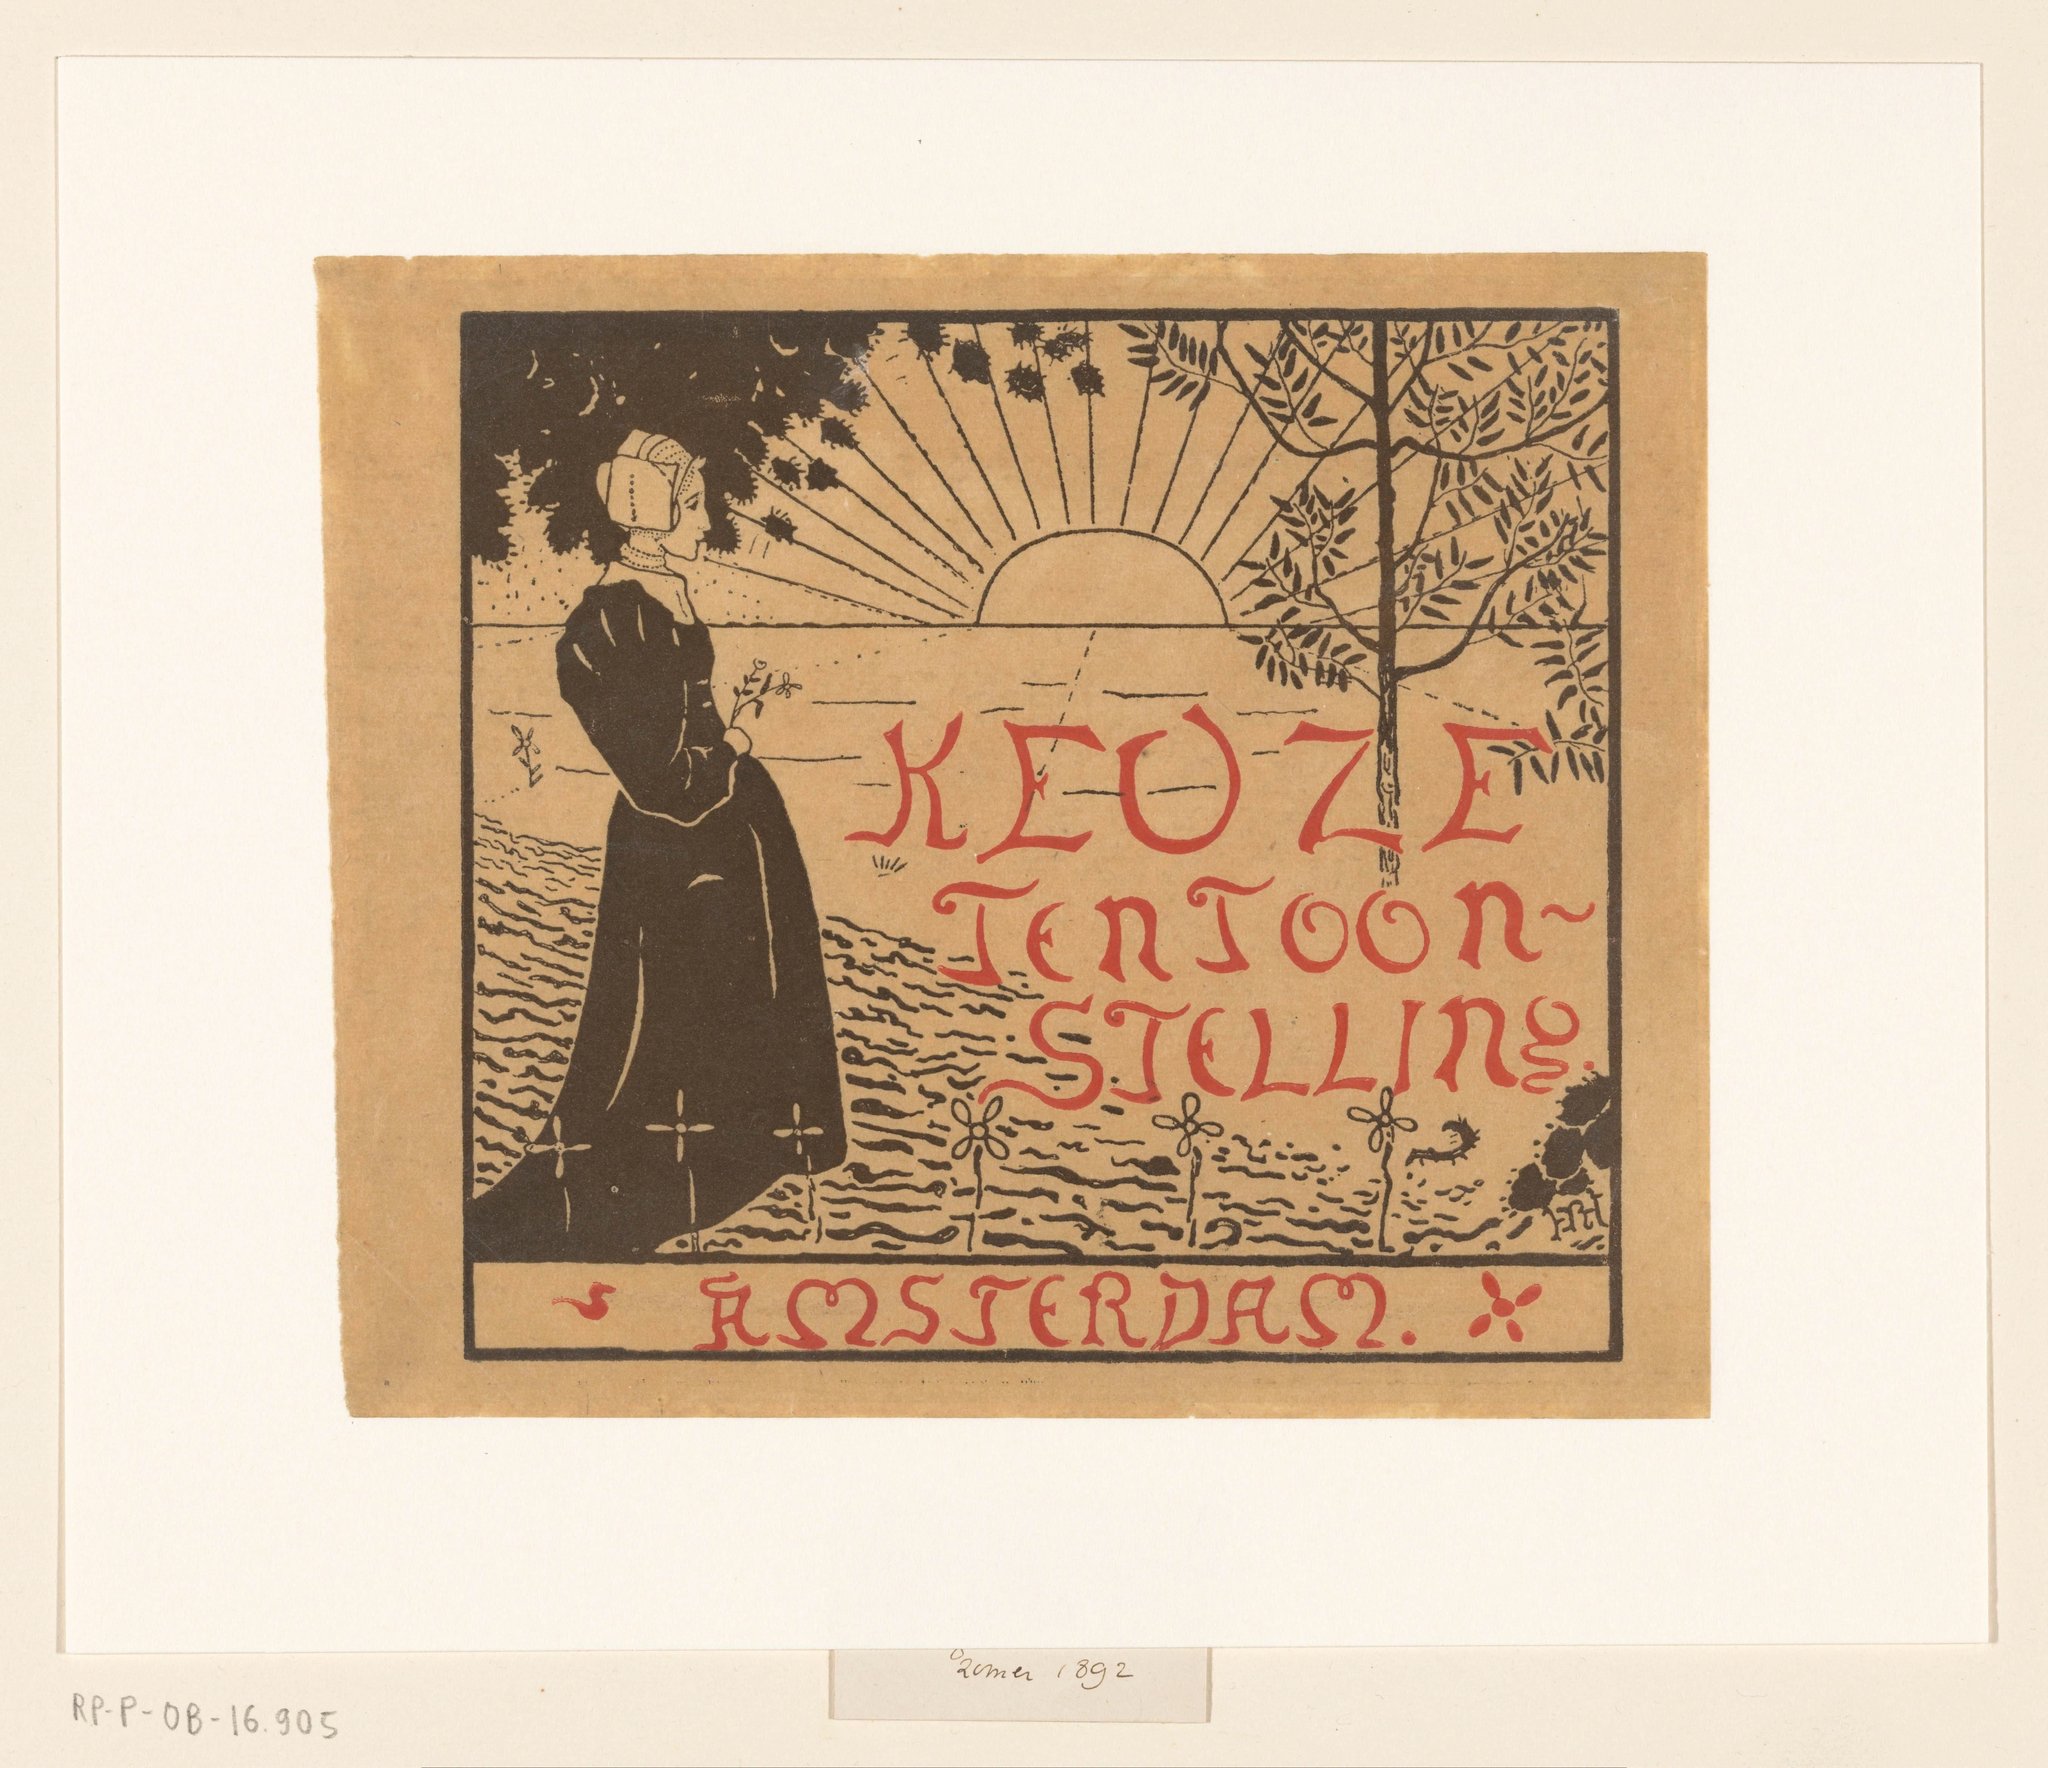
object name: design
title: Omslagontwerp voor: Catalogus der Keuze-tentoonstelling van hedendaagsche Nederlandsche kunst, 1892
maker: richard nicolaüs roland holst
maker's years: 1868-1938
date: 1892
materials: paper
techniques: woodcut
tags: sun as celestial body, folk costume, regional costume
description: Prent gebruikt voor: Catalogus der Keuze-tentoonstelling van hedendaagsche Nederlandsche kunst, bijeengebracht door een comité van schilders en studenten, in Arti et Amicitiae, ter gelegenheid van de Lustrum-feesten der Amsterdamsche Universiteit. Amsterdam: Arti et Amicitiae, 1892.